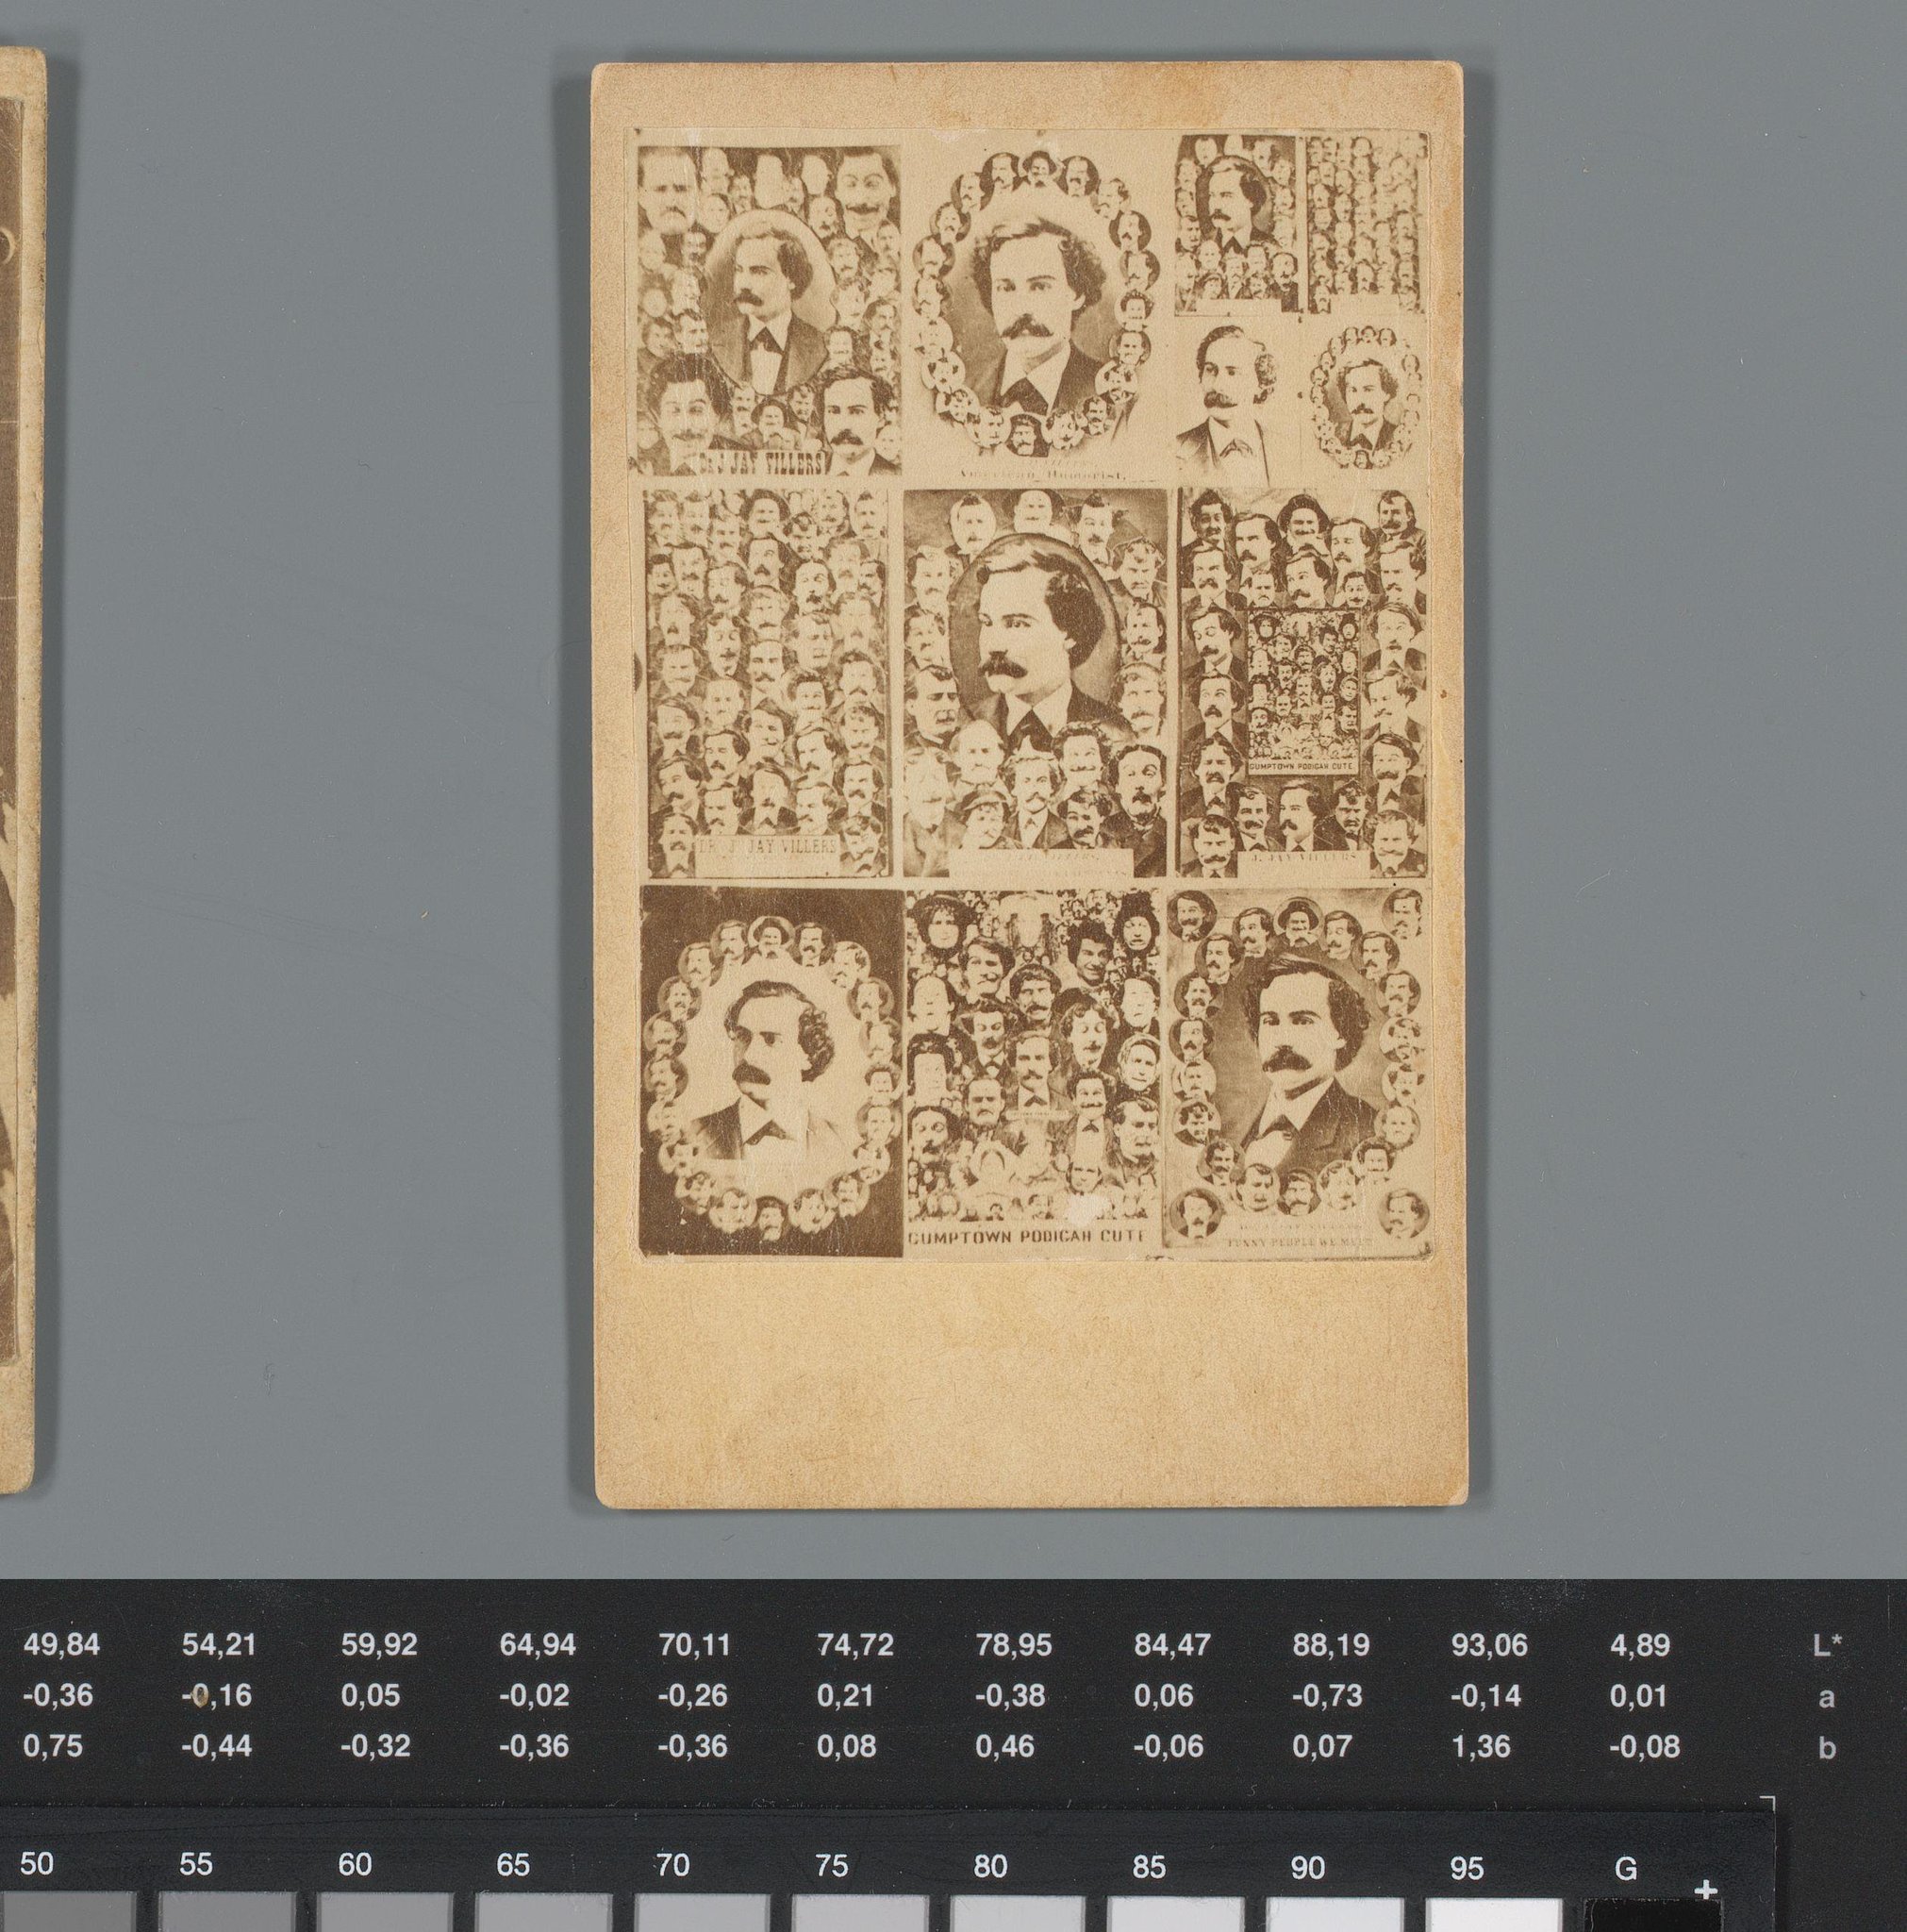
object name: photograph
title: Reclame voor voorstellingen van komiek Joseph Jay Villers met een collage van zijn portretten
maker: Anonymous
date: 1850-1915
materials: cardboard, photographic support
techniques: albumen print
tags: performance, advertising, historical persons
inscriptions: inscription: ‘Dr. J. JAY VILLERS / The American Humorist. / Subjects: / 1. FUNNY PEOPLE WE MEET / 2. HUMORISTS OF THE PAST AND PRESENT / 3. ECCENTRIC CHARACTER / 4. MIRTH AND MIMICRY (...)’